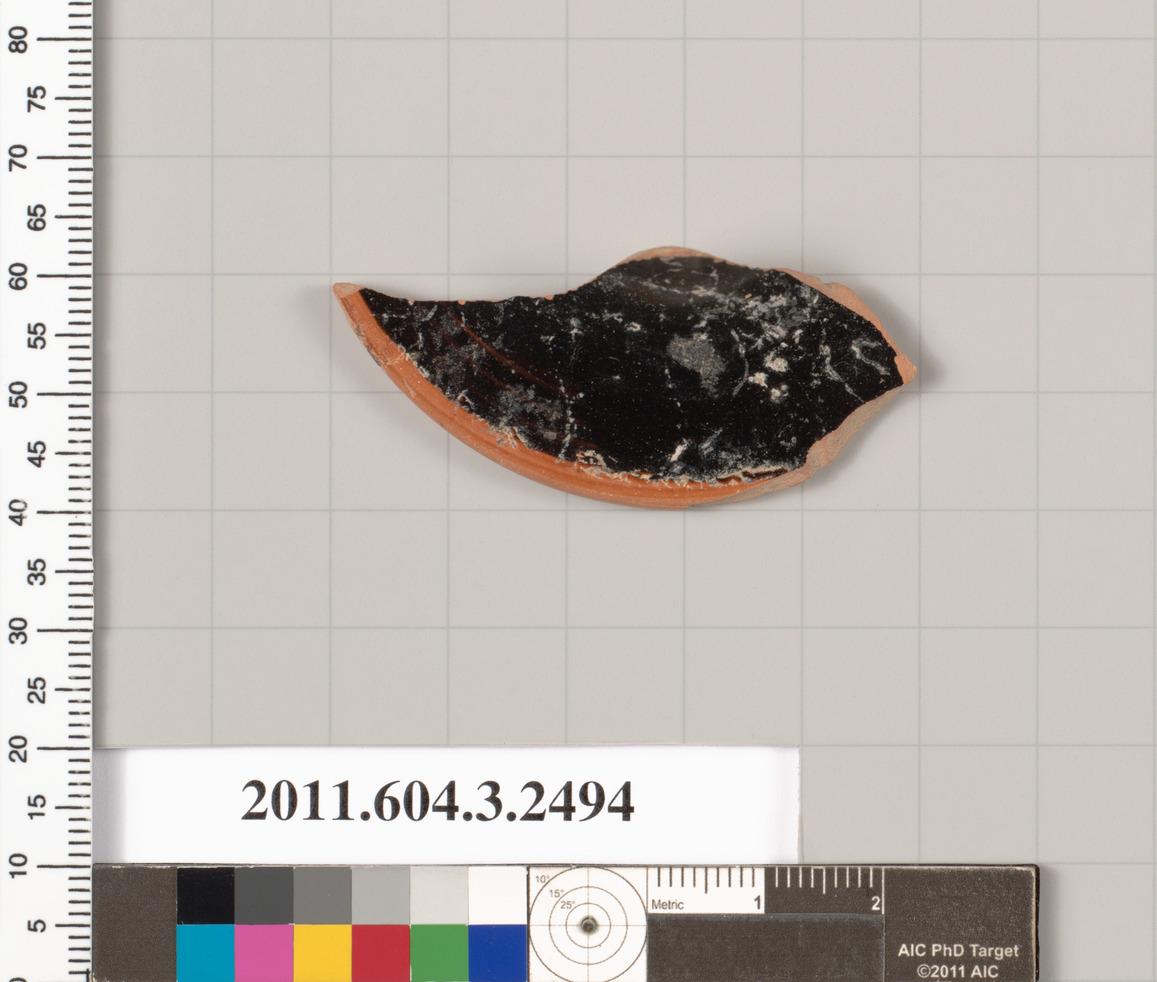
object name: kylix fragment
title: Terracotta fragment of a kylix (drinking cup)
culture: greek, attic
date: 600-401 BCE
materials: terracotta